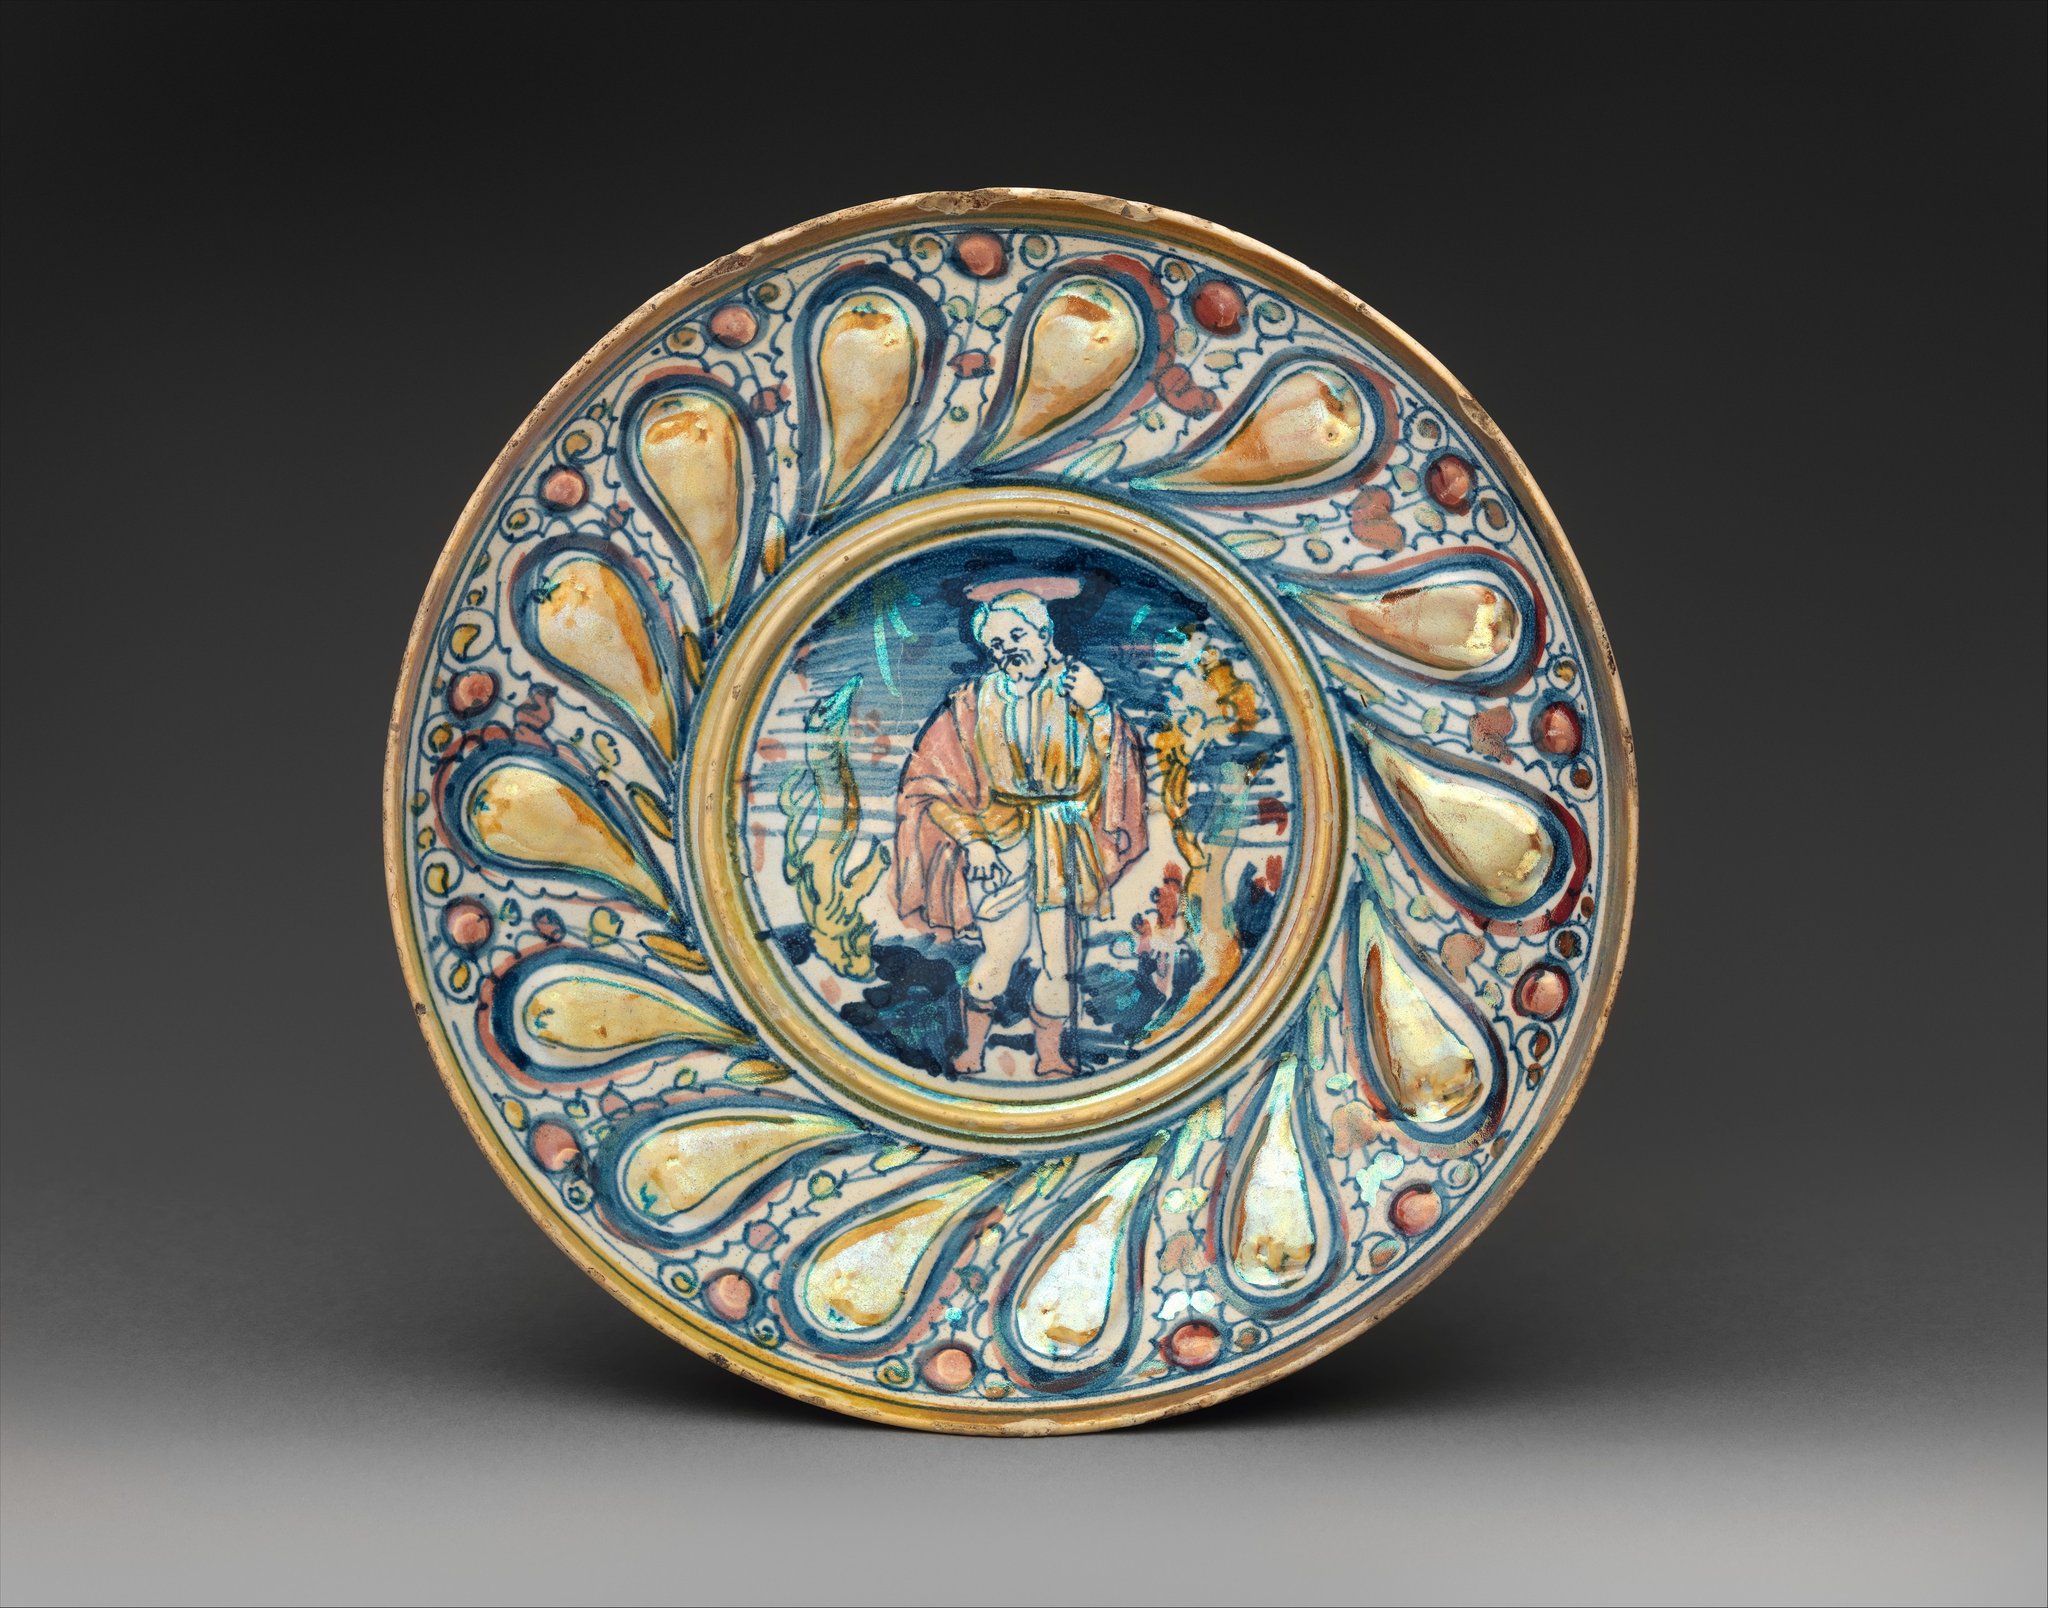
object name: bowl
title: Bowl with Saint Roch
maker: maestro giorgio andreoli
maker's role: artist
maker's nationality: italian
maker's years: 1500-1550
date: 1530-1540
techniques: maiolica, glazing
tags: men